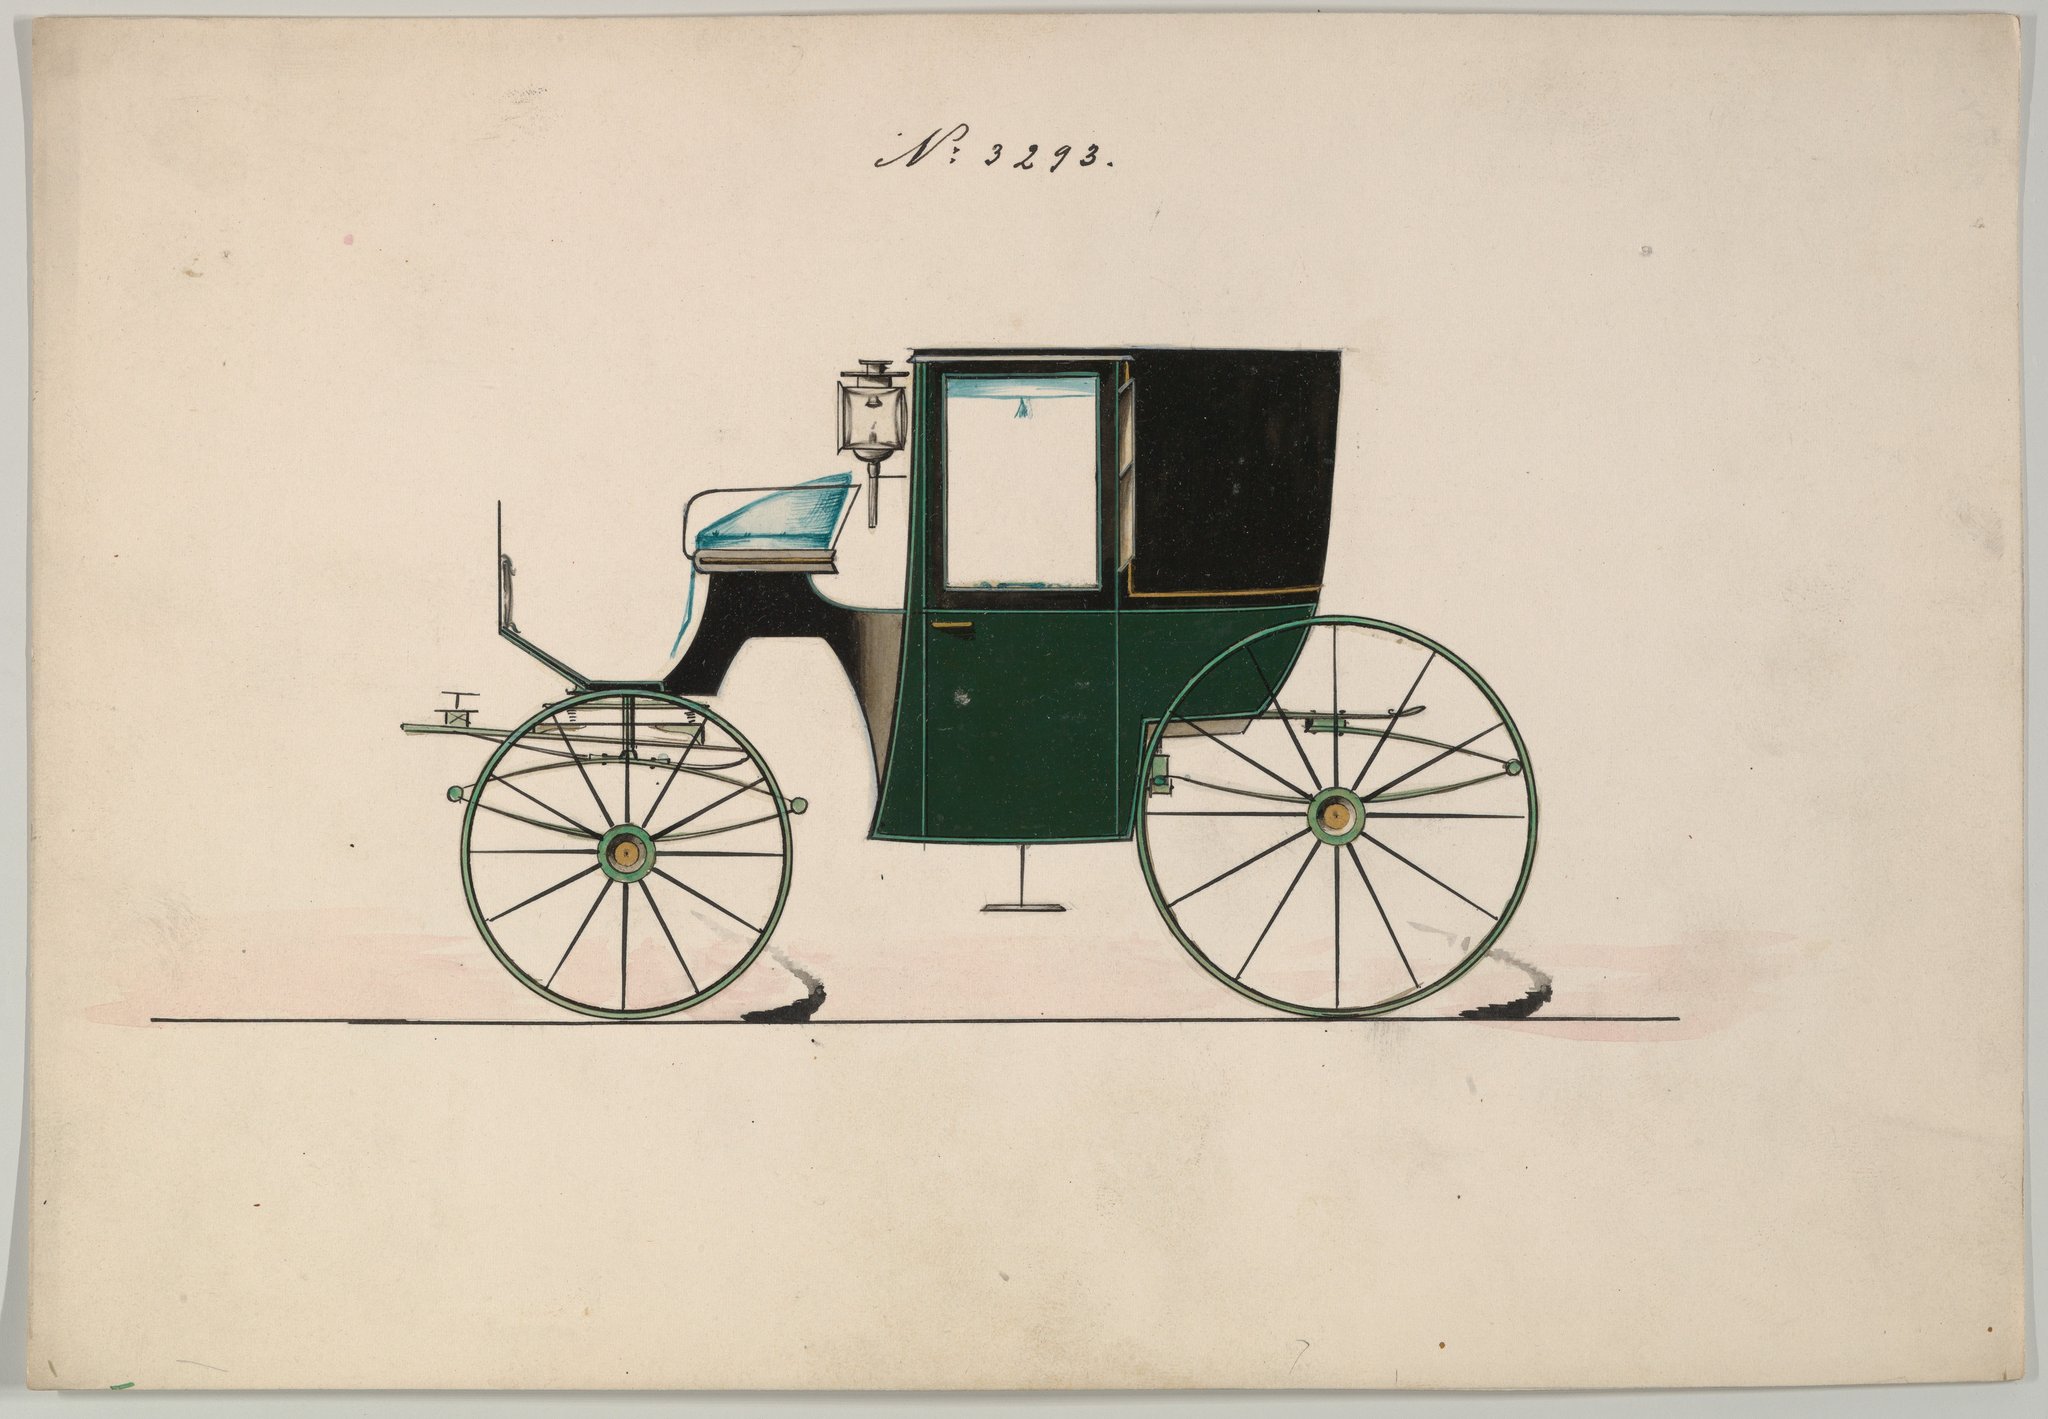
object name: drawing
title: Brougham #3293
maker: brewster & co.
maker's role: manufacturer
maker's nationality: american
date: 1877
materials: gouache, ink, watercolor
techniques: pen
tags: carriages